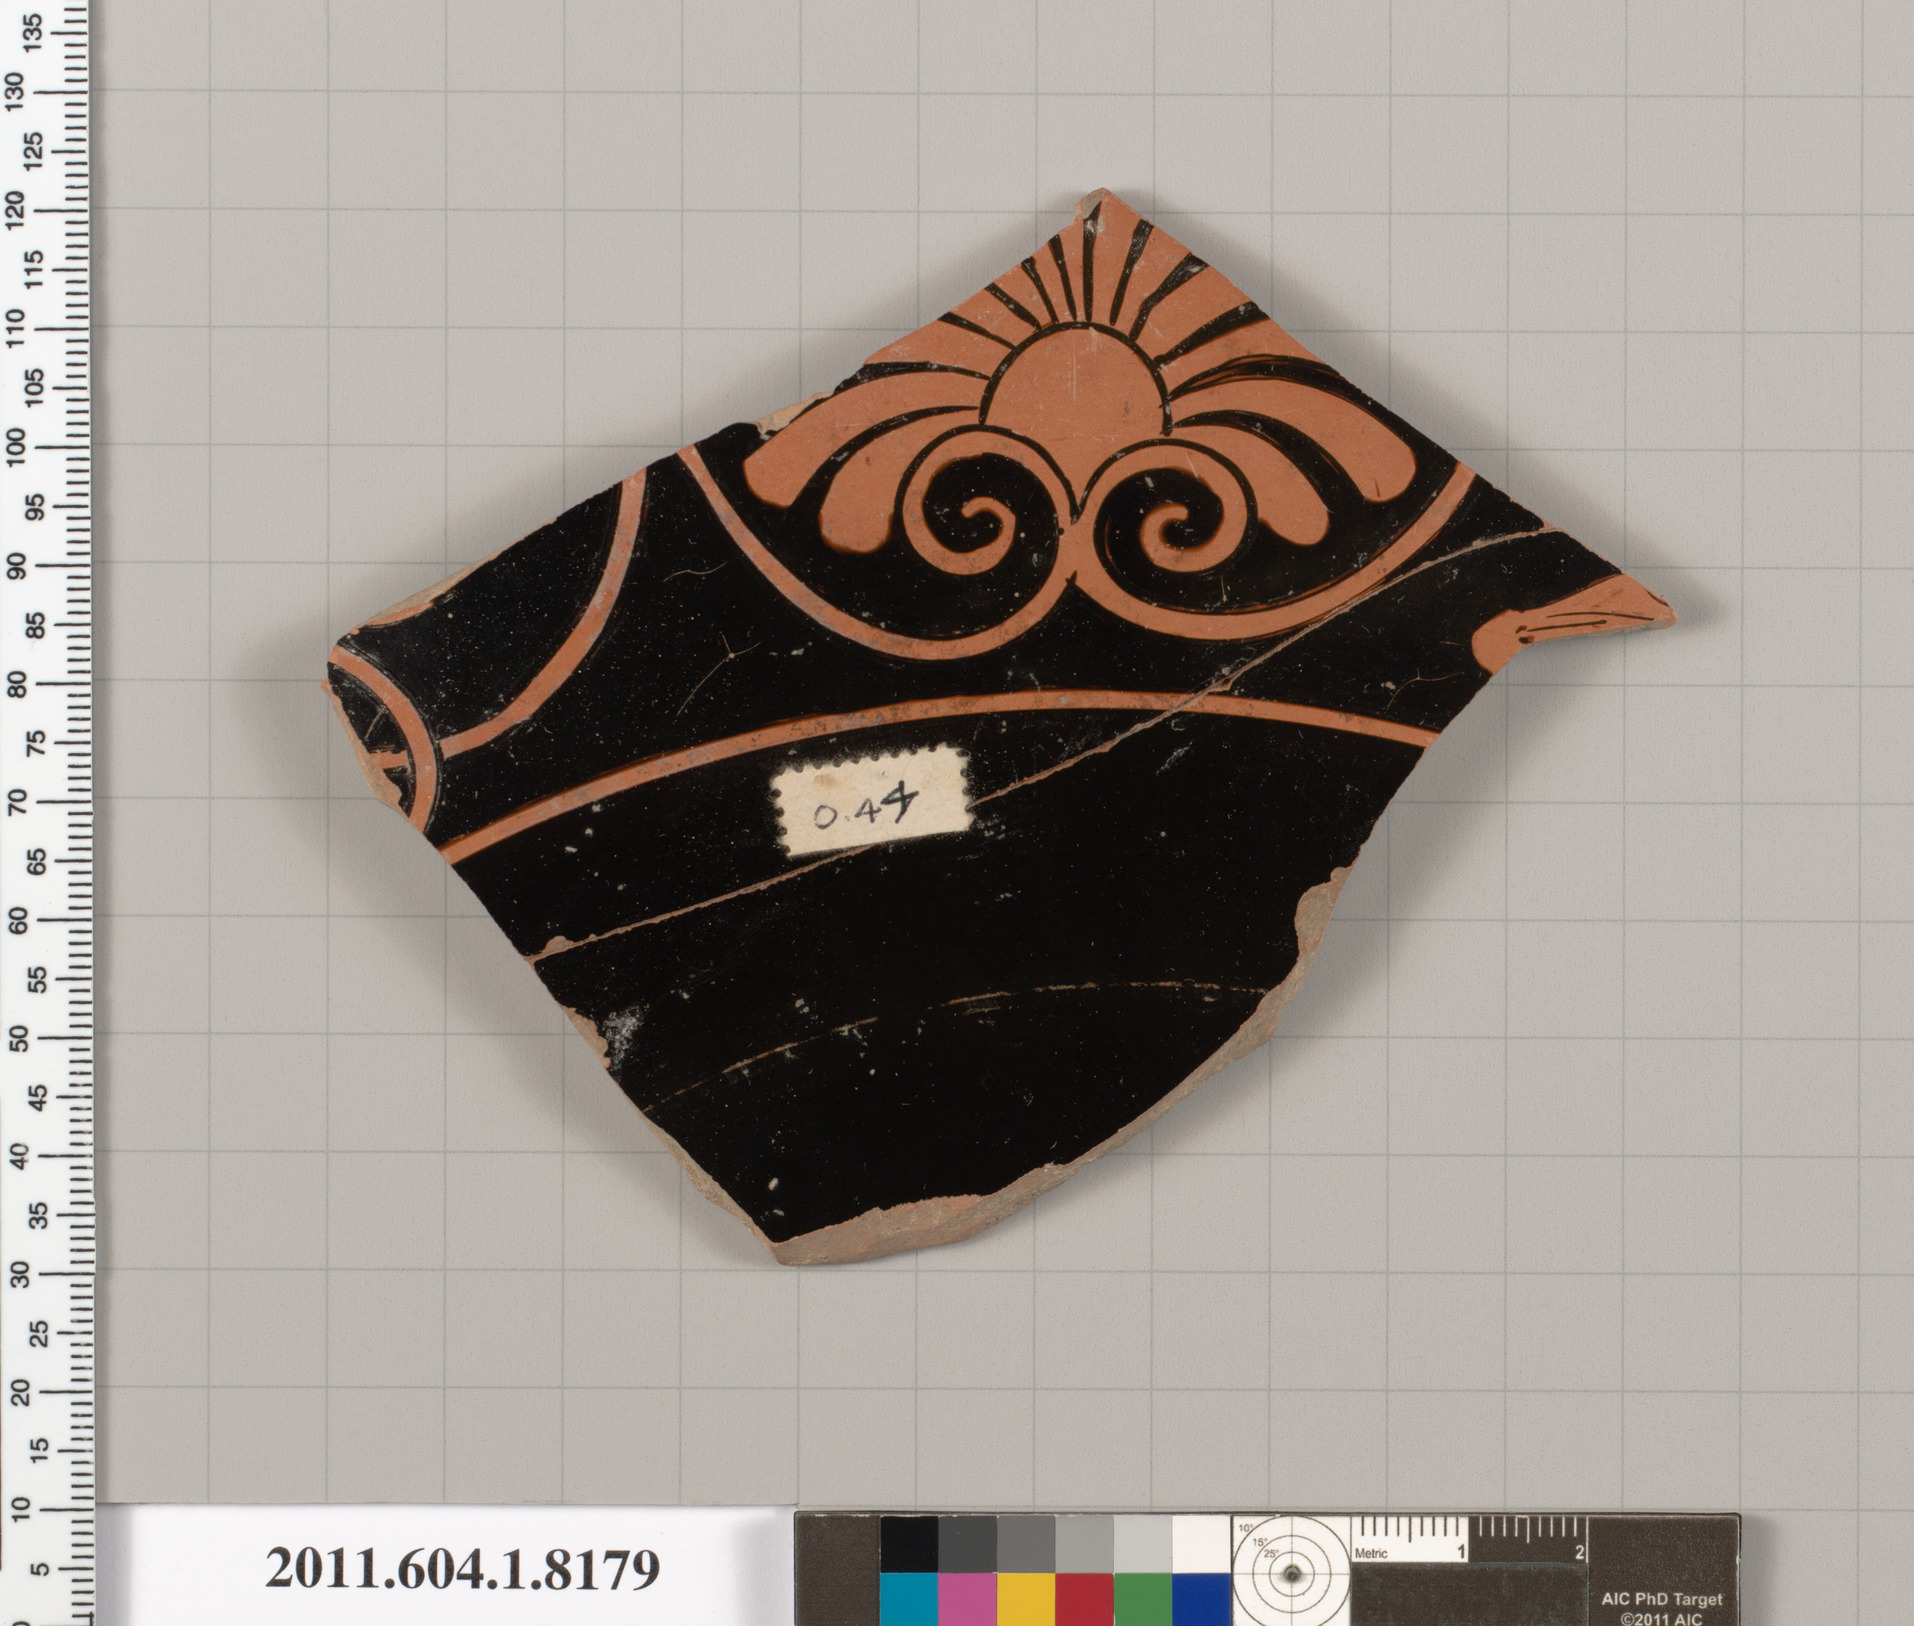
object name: kylix fragment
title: Terracotta fragment of a kylix (drinking cup)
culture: greek, attic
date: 520-510 BCE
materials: terracotta